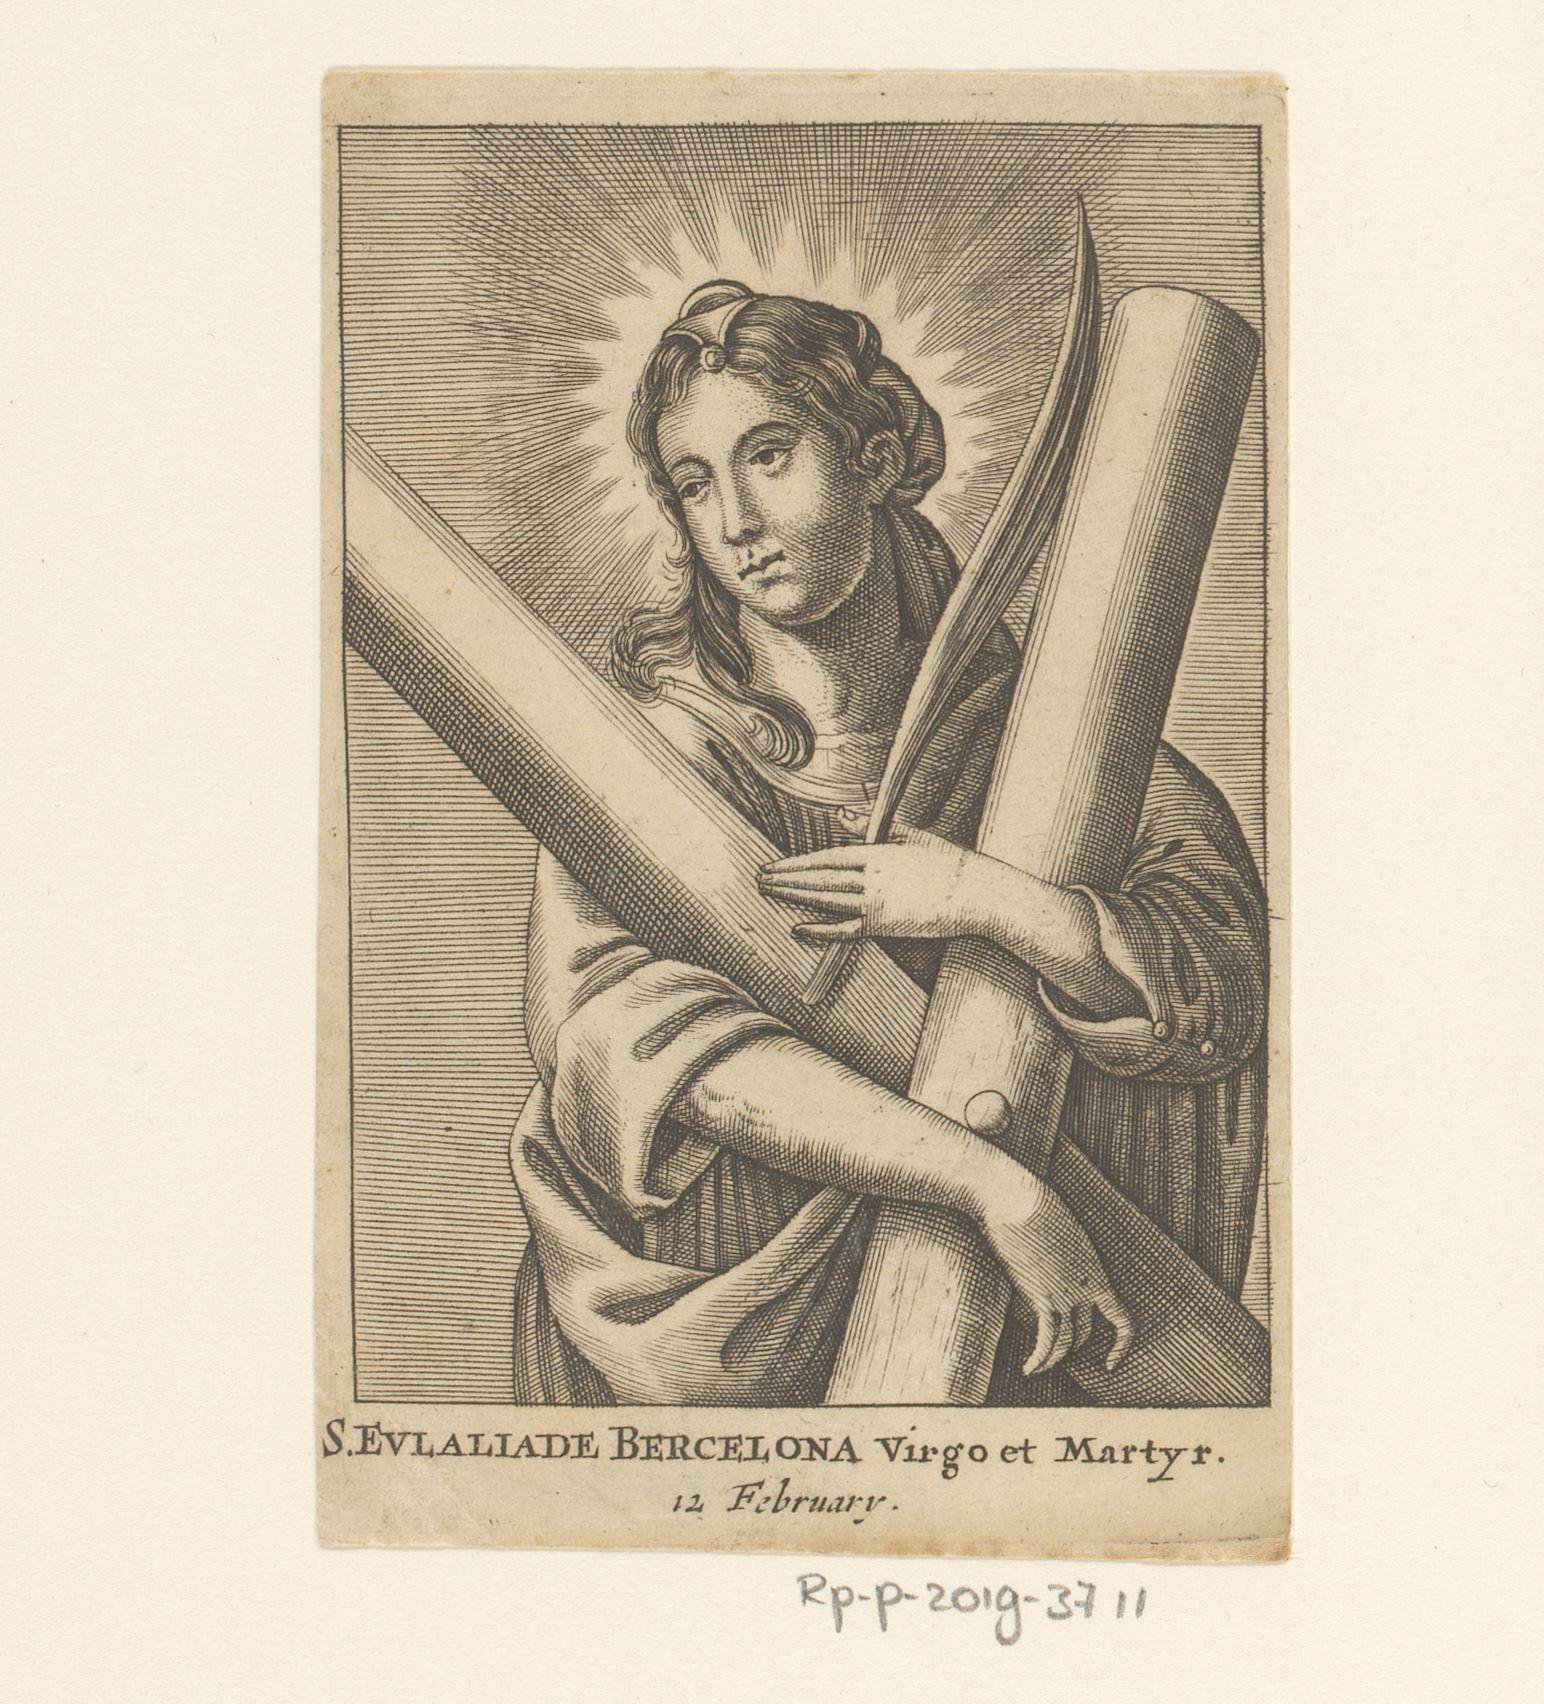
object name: print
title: S. Eulaliade Bercelona Virgo et Martyr. 12 February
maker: Anonymous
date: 1600-1699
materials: paper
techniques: engraving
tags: female saints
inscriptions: collector's mark: Lugt 2228